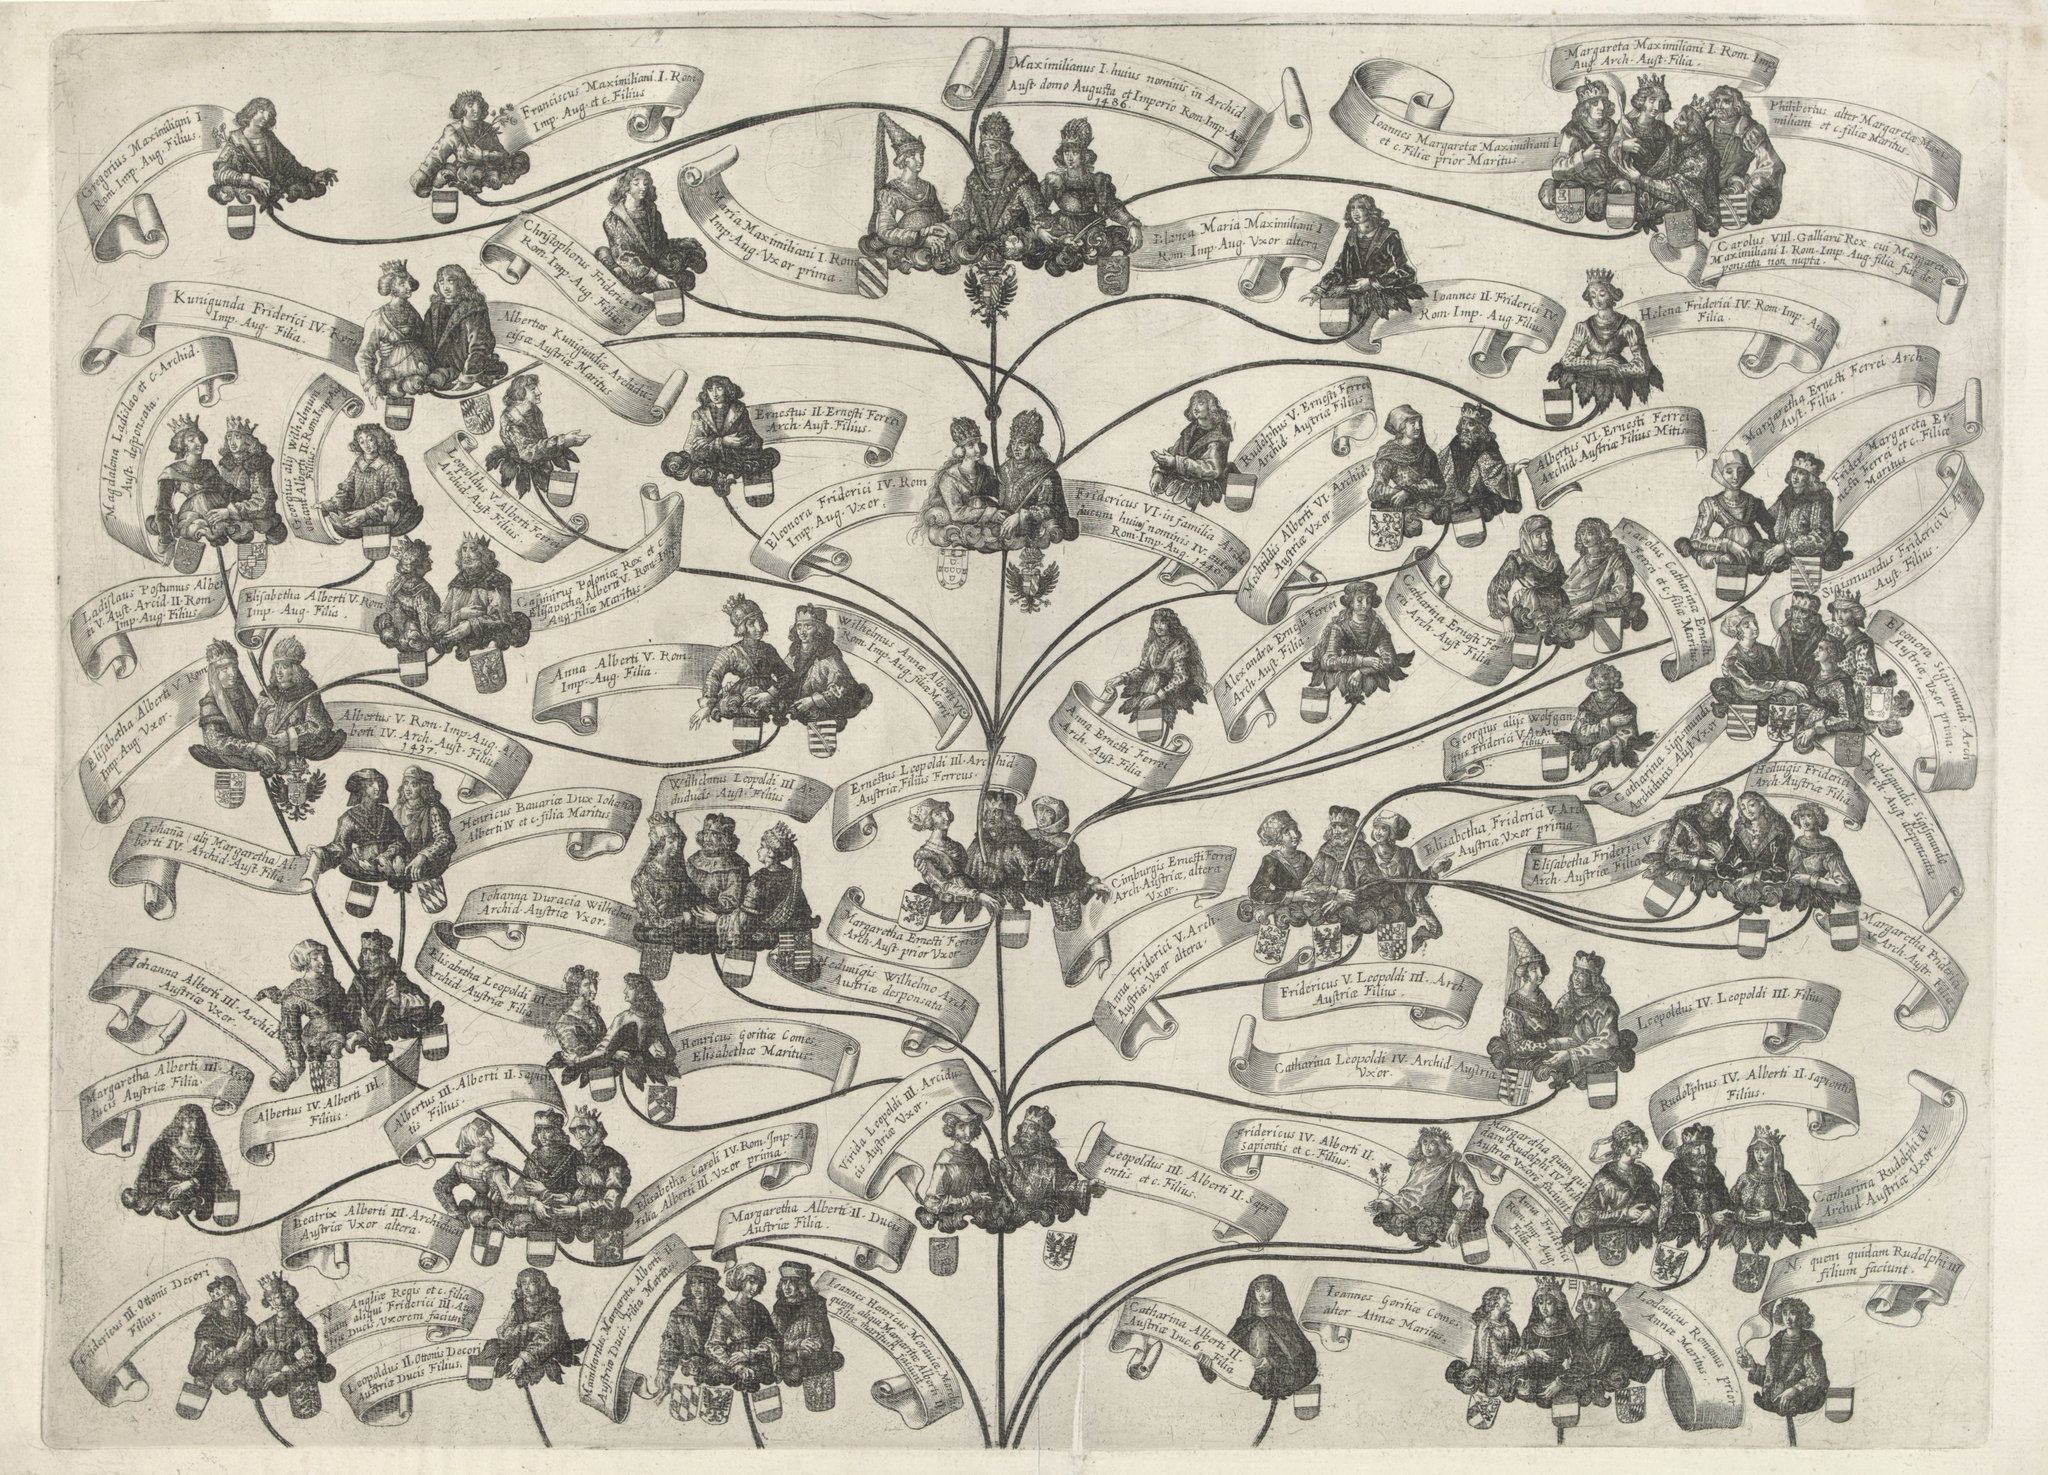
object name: print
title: Stamboom van het Habsburgse huis, serie A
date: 1629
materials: paper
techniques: engraving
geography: prague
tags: family lineage, pedigree, genealogical tree or table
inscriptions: collector's mark: Lugt 2228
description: De prent behoort tot een serie bestaande uit zes prenten, waarvan één titelprent. De laatste prent is van de hand van een anonieme kunstenaar en de overige prenten zijn vervaardigd door Aegidius Sadeler.